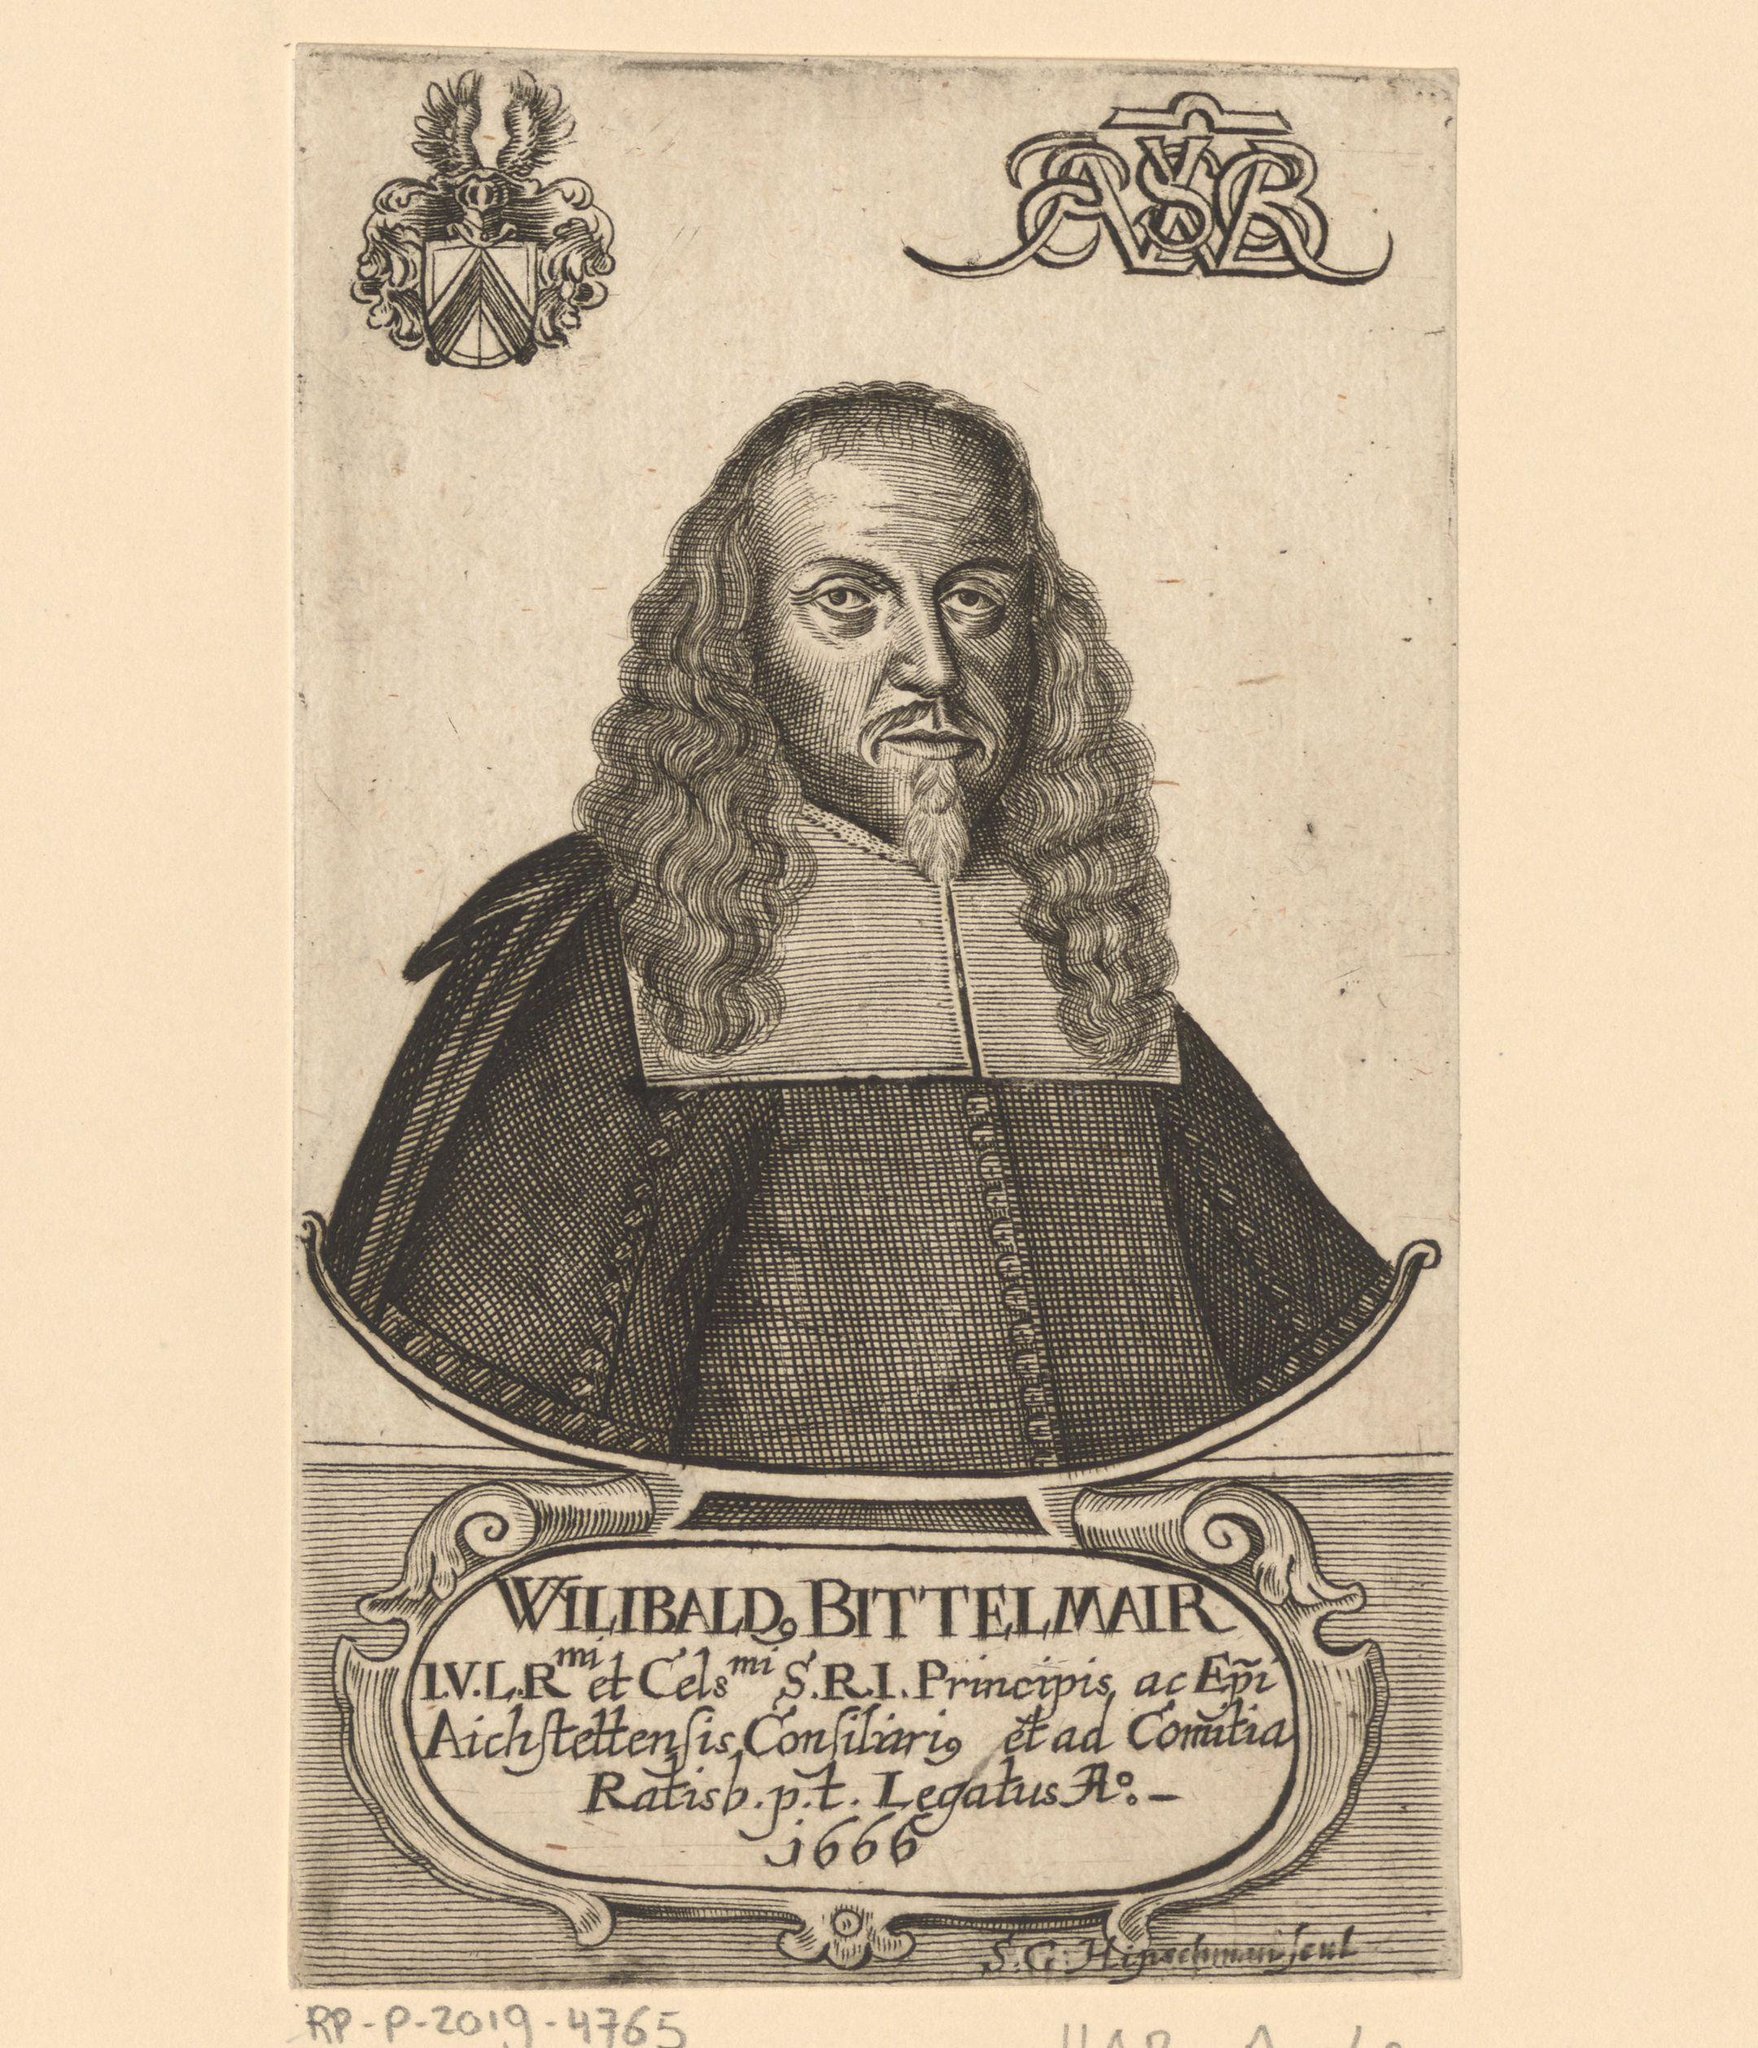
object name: print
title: Portret van Willibald Bittelmair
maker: sigmund gabriel hipschmann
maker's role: painter, print maker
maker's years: 1639-1683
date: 1666-1683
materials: paper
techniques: engraving, etching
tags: historical persons, armorial bearing, heraldry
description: Met linksboven zijn wapenschild en rechtsboven zijn monogram.